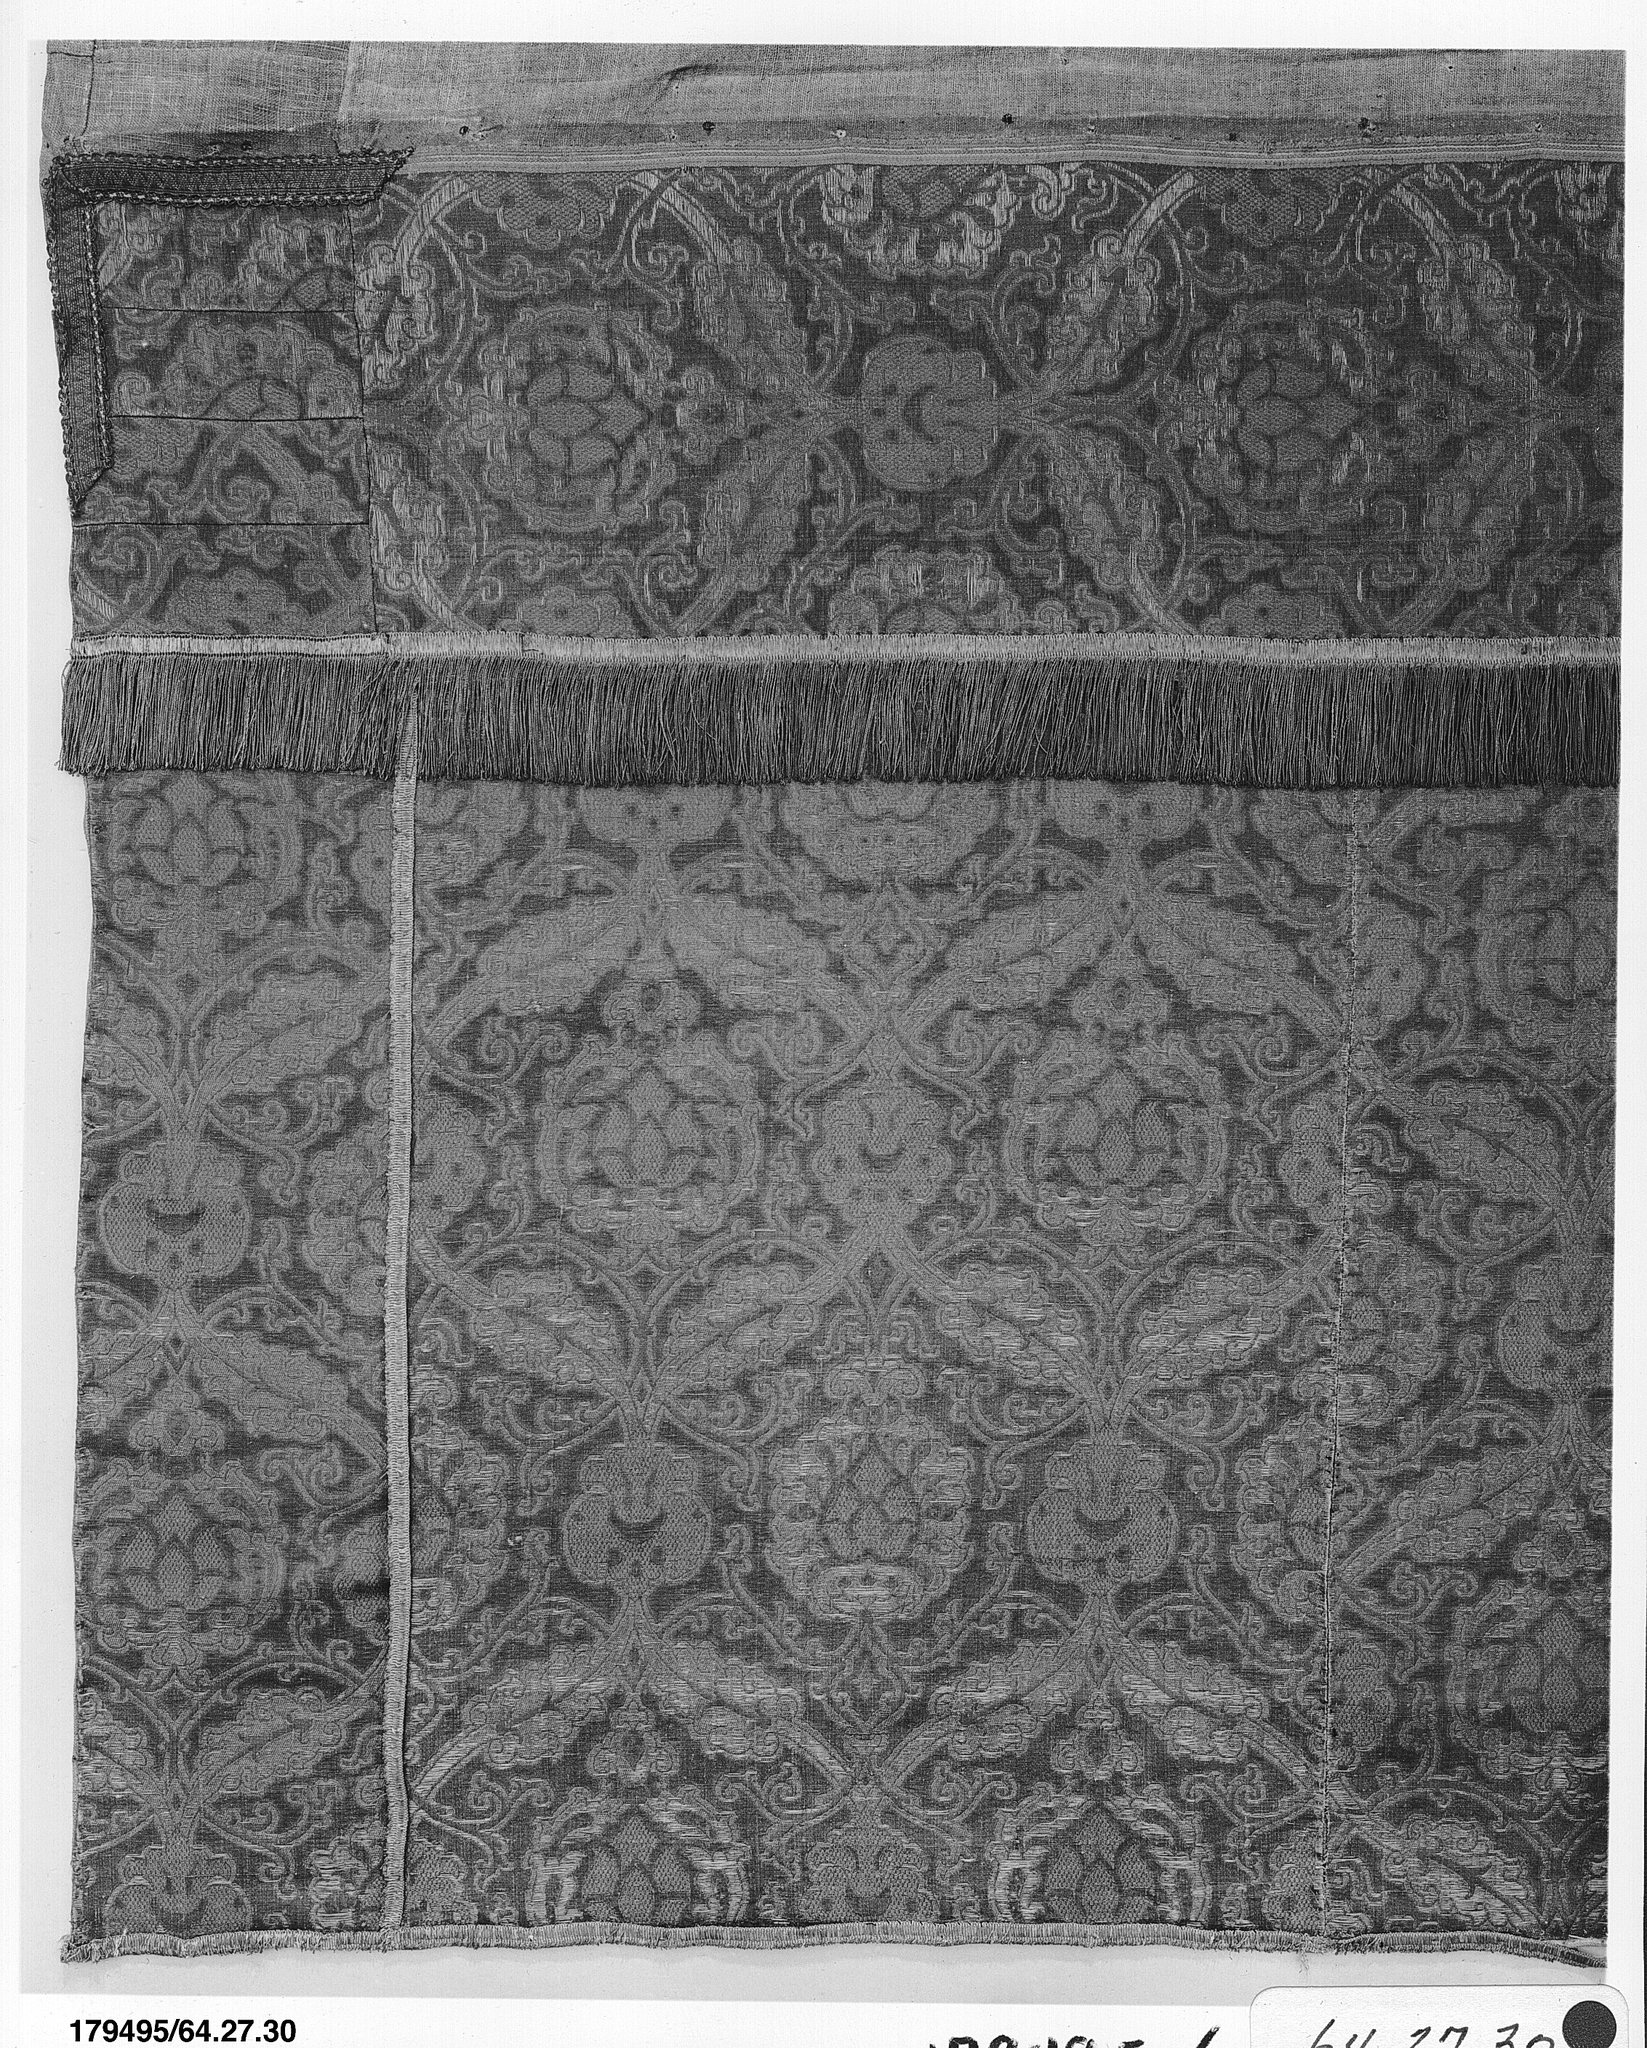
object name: antependium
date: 1501-1600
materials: linen, metal thread, silk